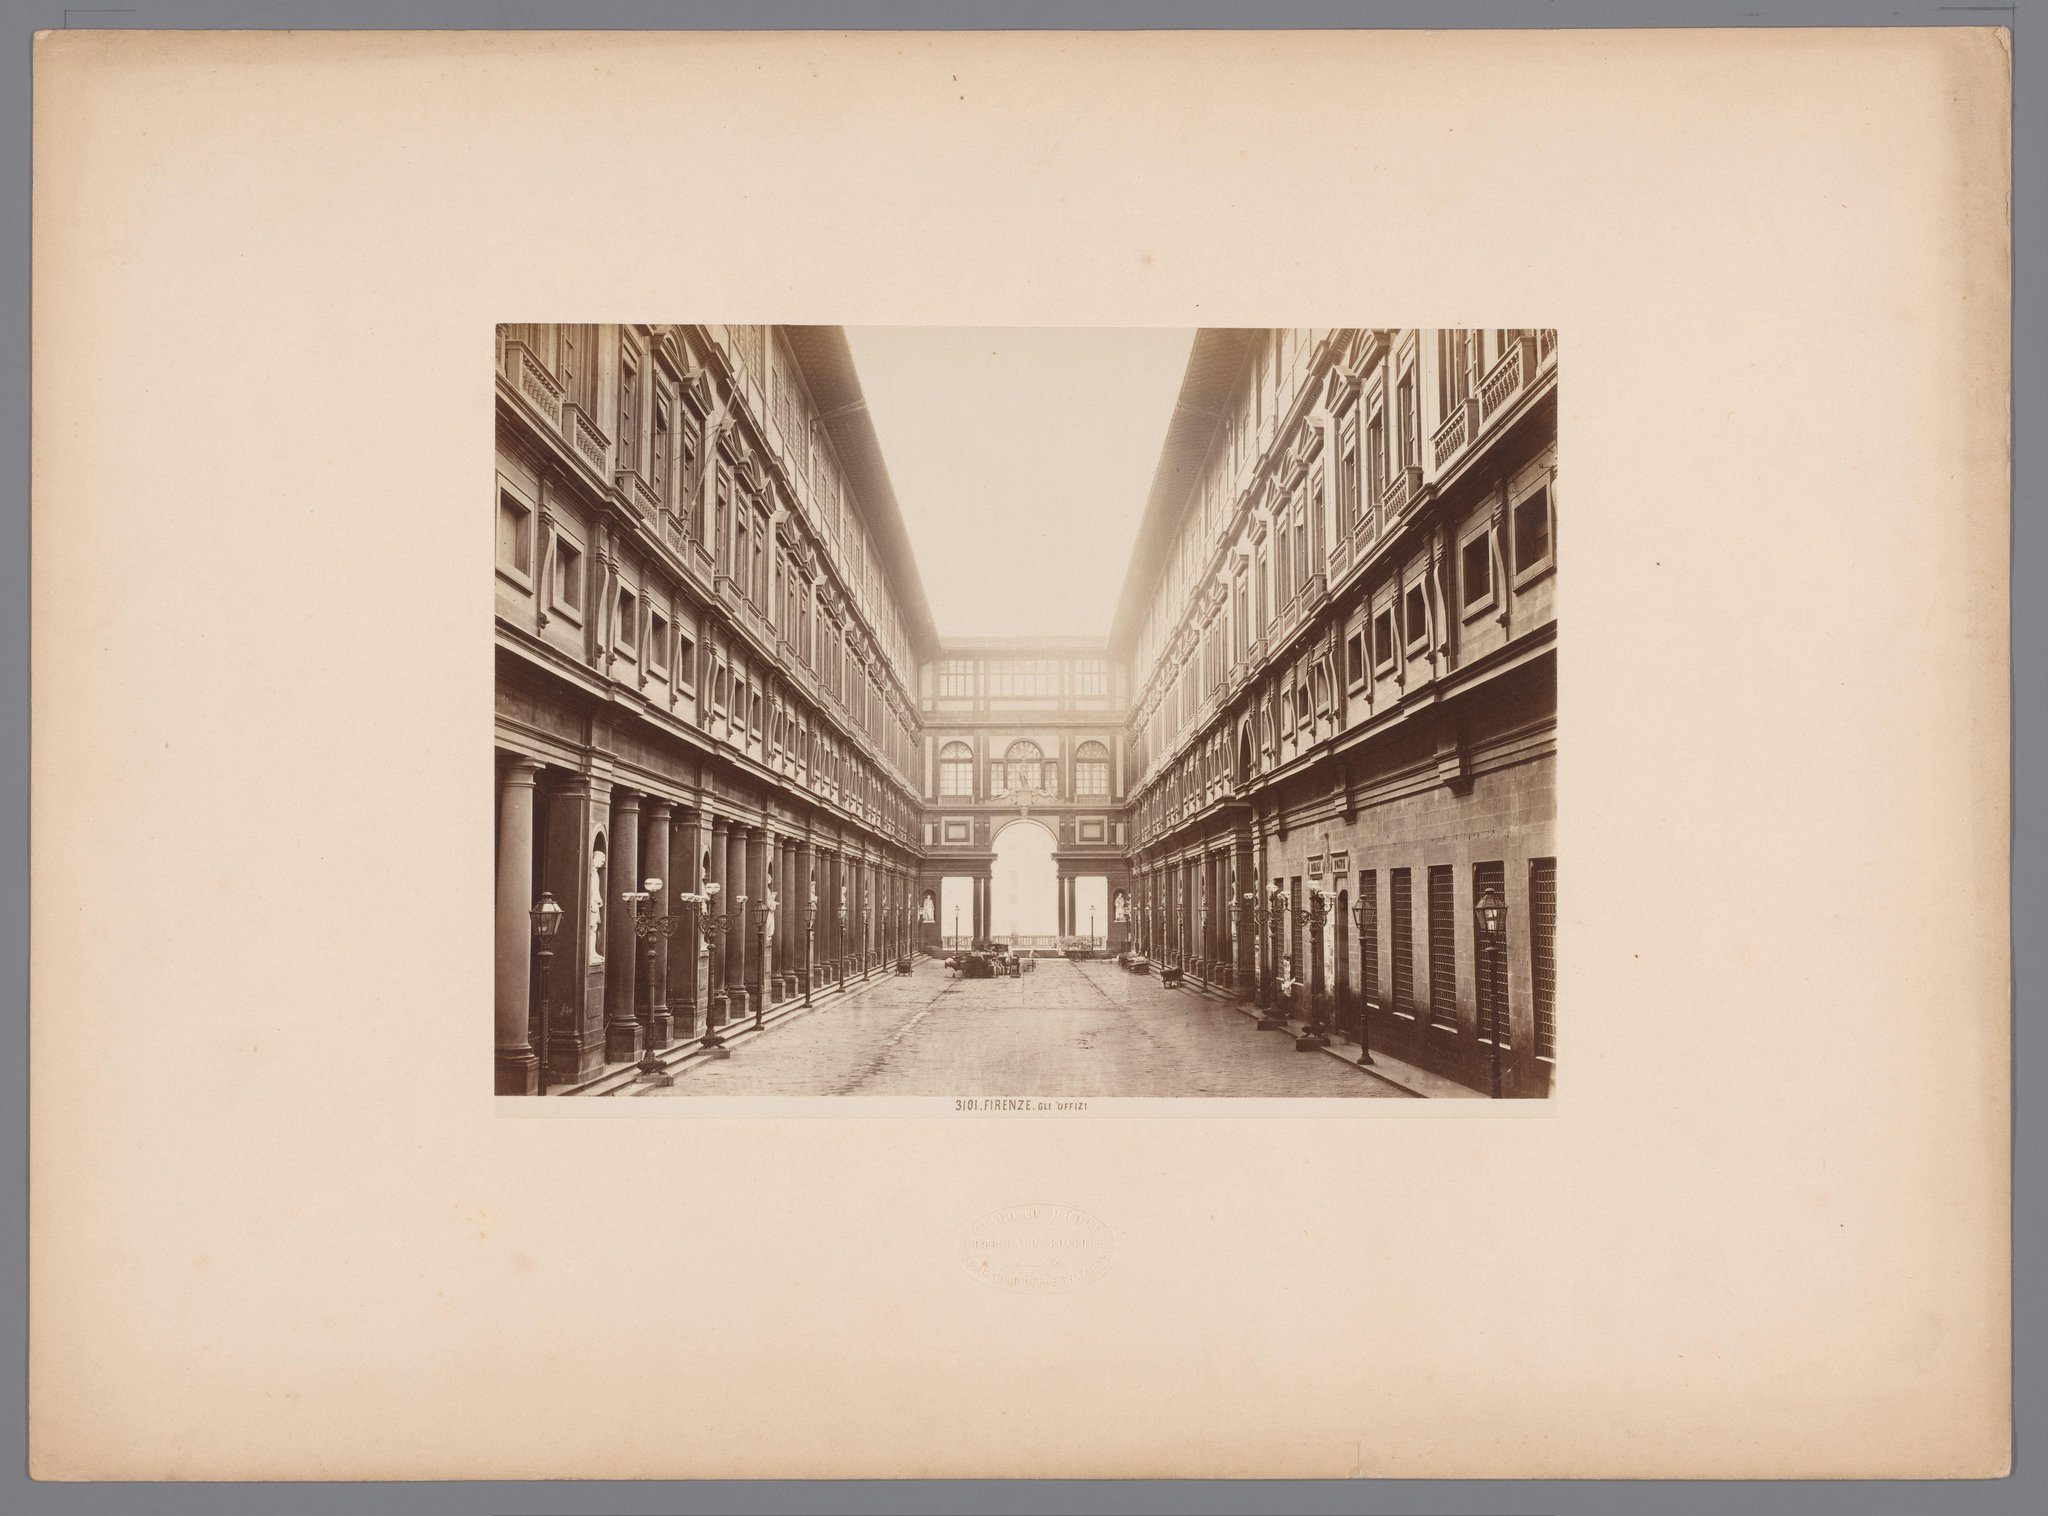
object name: photograph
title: Galleria degli Uffizi te Florence, Italië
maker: giacomo brogi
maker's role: fotograaf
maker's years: 1822-1881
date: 1864-1881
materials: cardboard, paper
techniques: albumen print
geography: florence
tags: permanent exhibition, museum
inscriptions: address: ‘GIACOMO BROGI/ FOTOGRAFO-EDITORE/ FIRENZE/ LUNG ARNO DELLE GRAZIE 15’, number: ‘3101.’